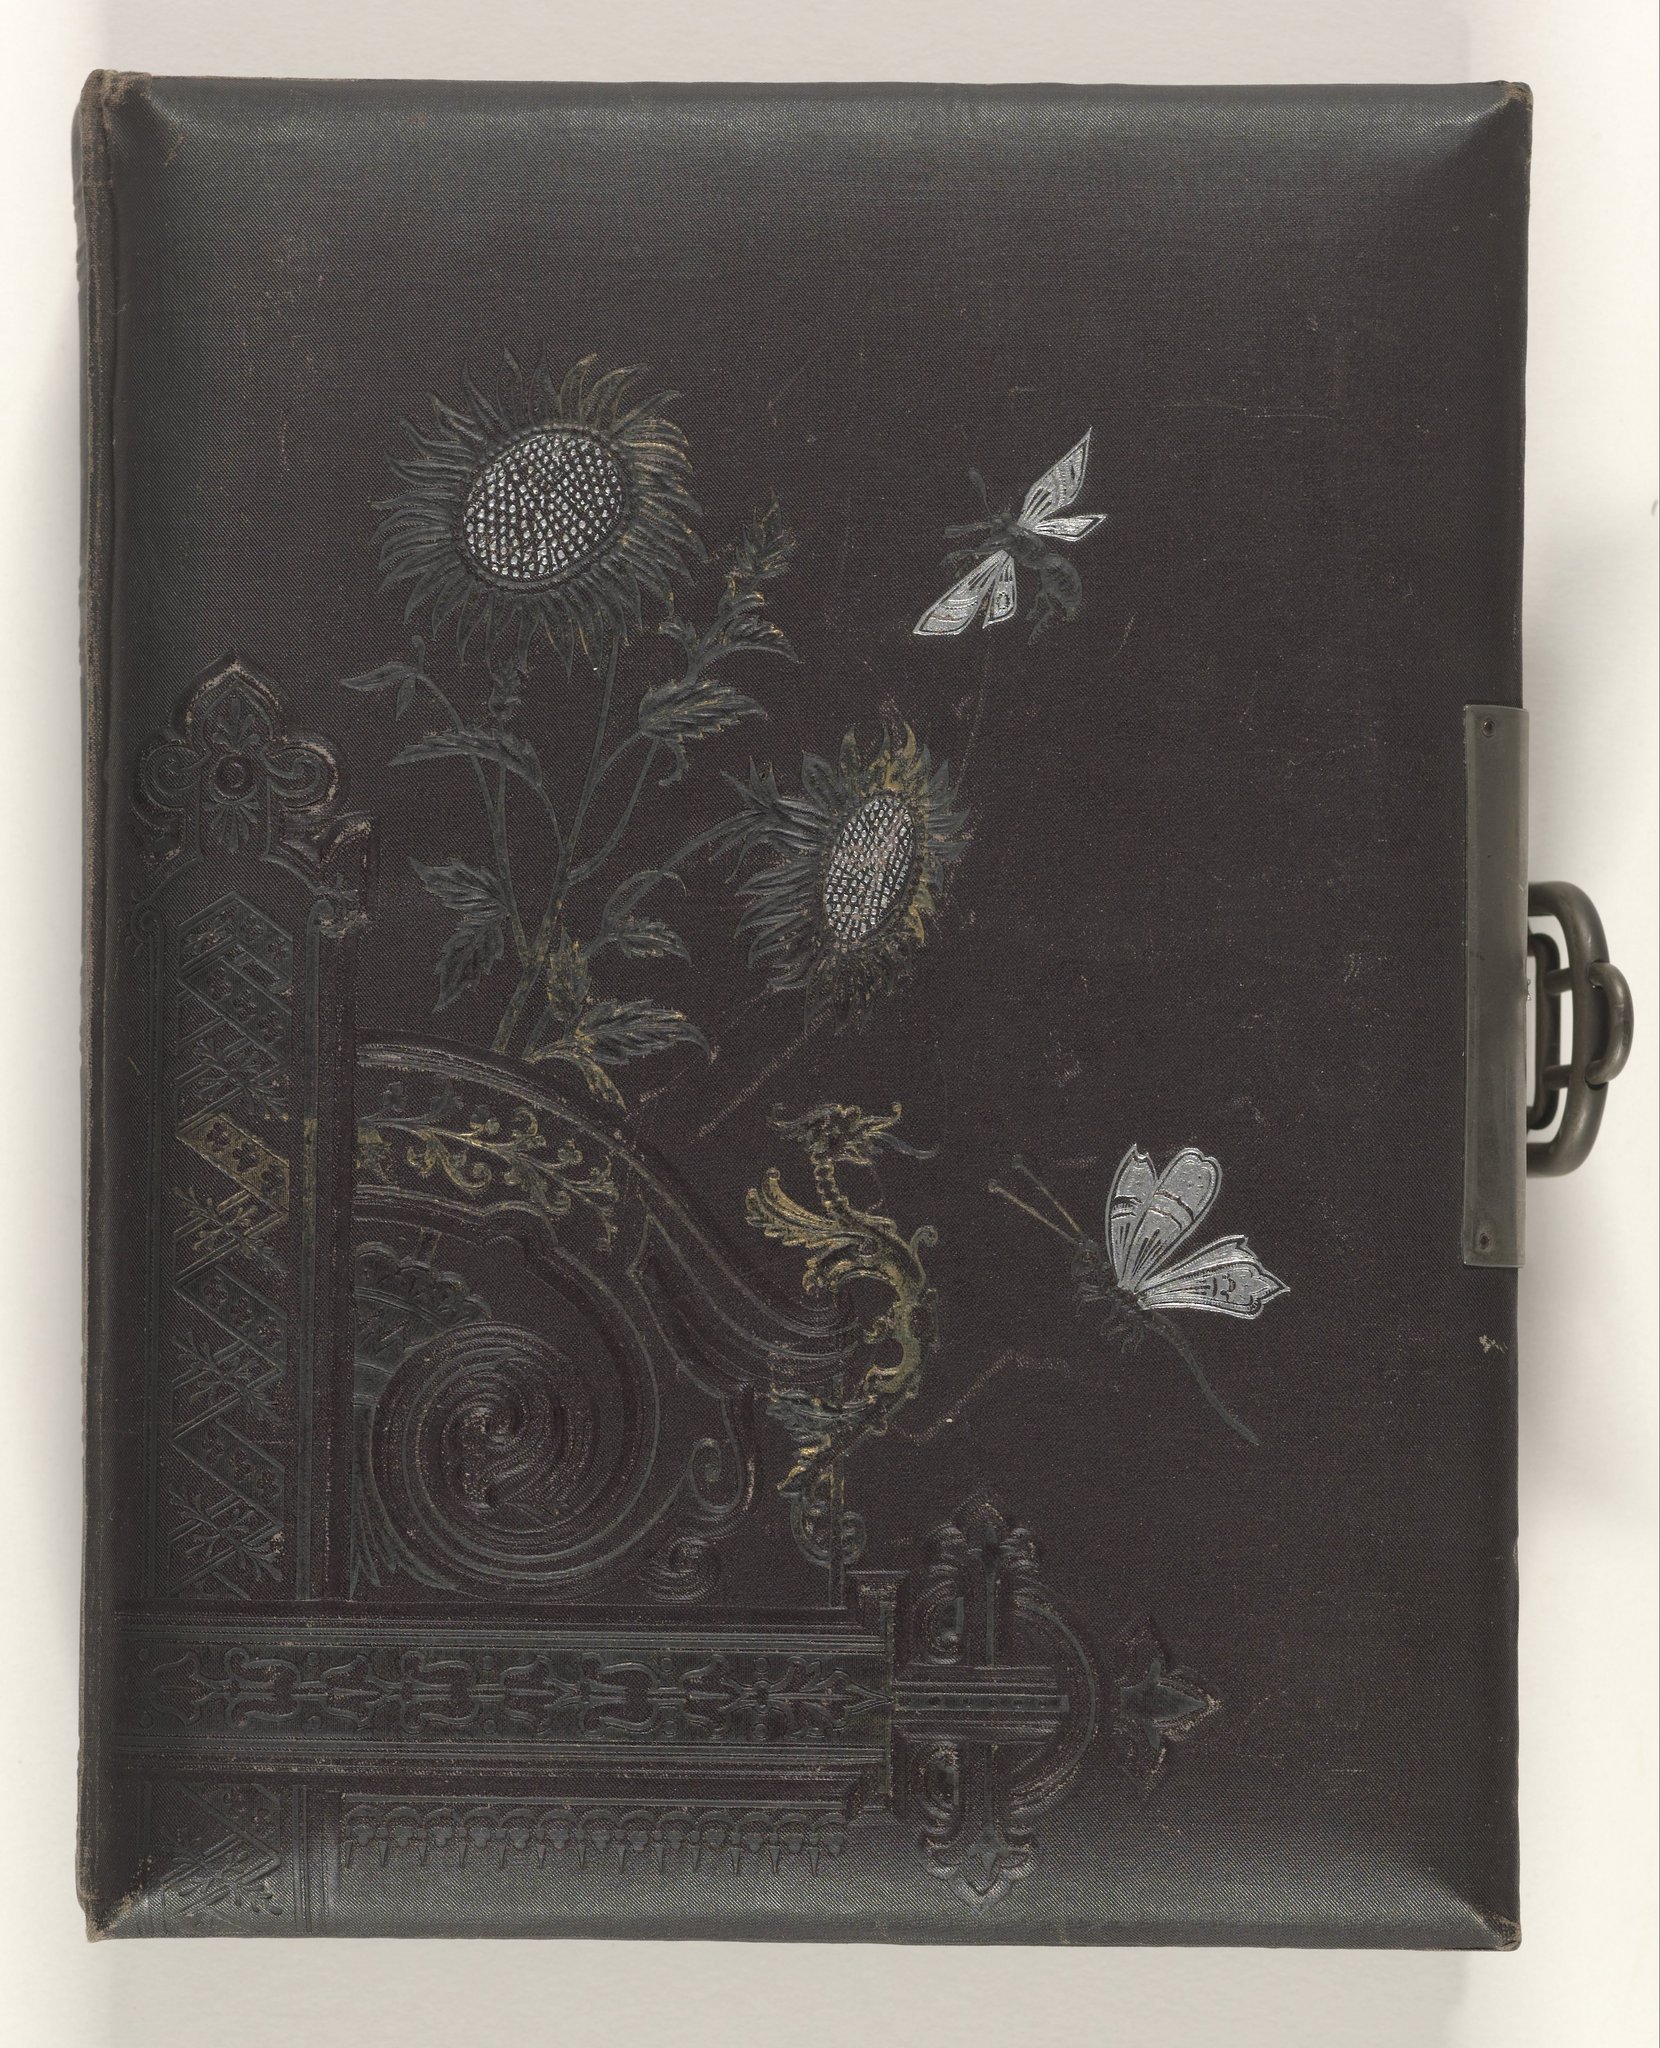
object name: slip in album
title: Fotoalbum van Leidse studenten met 105 foto's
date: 1870-1930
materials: cardboard, linen, metal, paper, photographic support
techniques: albumen print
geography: netherlands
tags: historical persons - bb - woman, historical persons, student life, netherlands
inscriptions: collector's mark: ‘DIENST/ VERSPREIDE/ RIJKSKOLLEKTIES/ (...) A666’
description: Fotoalbum met 21 bladen met in totaal 105 foto's. Het album bevat 102 cartes-de-visite en 3 kabinetfoto's in met gouden lijnen omkaderde rechthoekige en ovale passe-partouts. Niet alle passe-partouts in het album zijn gevuld. Afgebeeld zijn portretten van jonge mannen, vermoedelijk studenten. Bij een groot deel van de foto's is een naam op de achterzijde geschreven, vermoedelijk van de geportretteerde. Van 11 van de geportretteerden is de naam bekend, onder wie Arnold Cornelis Maas Geesteranus en Cornelis Hoogendijk. Het merendeel van de foto's is vervaardigd in Leiden, door de fotografen Jan Goedeljee, A. Th. Baert, Antonius Joannes van der Stok en Hendrik Jonker. De overige foto's zijn vervaardigd op andere plaatsen in Nederland. Van 2 foto's is de fotograaf anoniem.